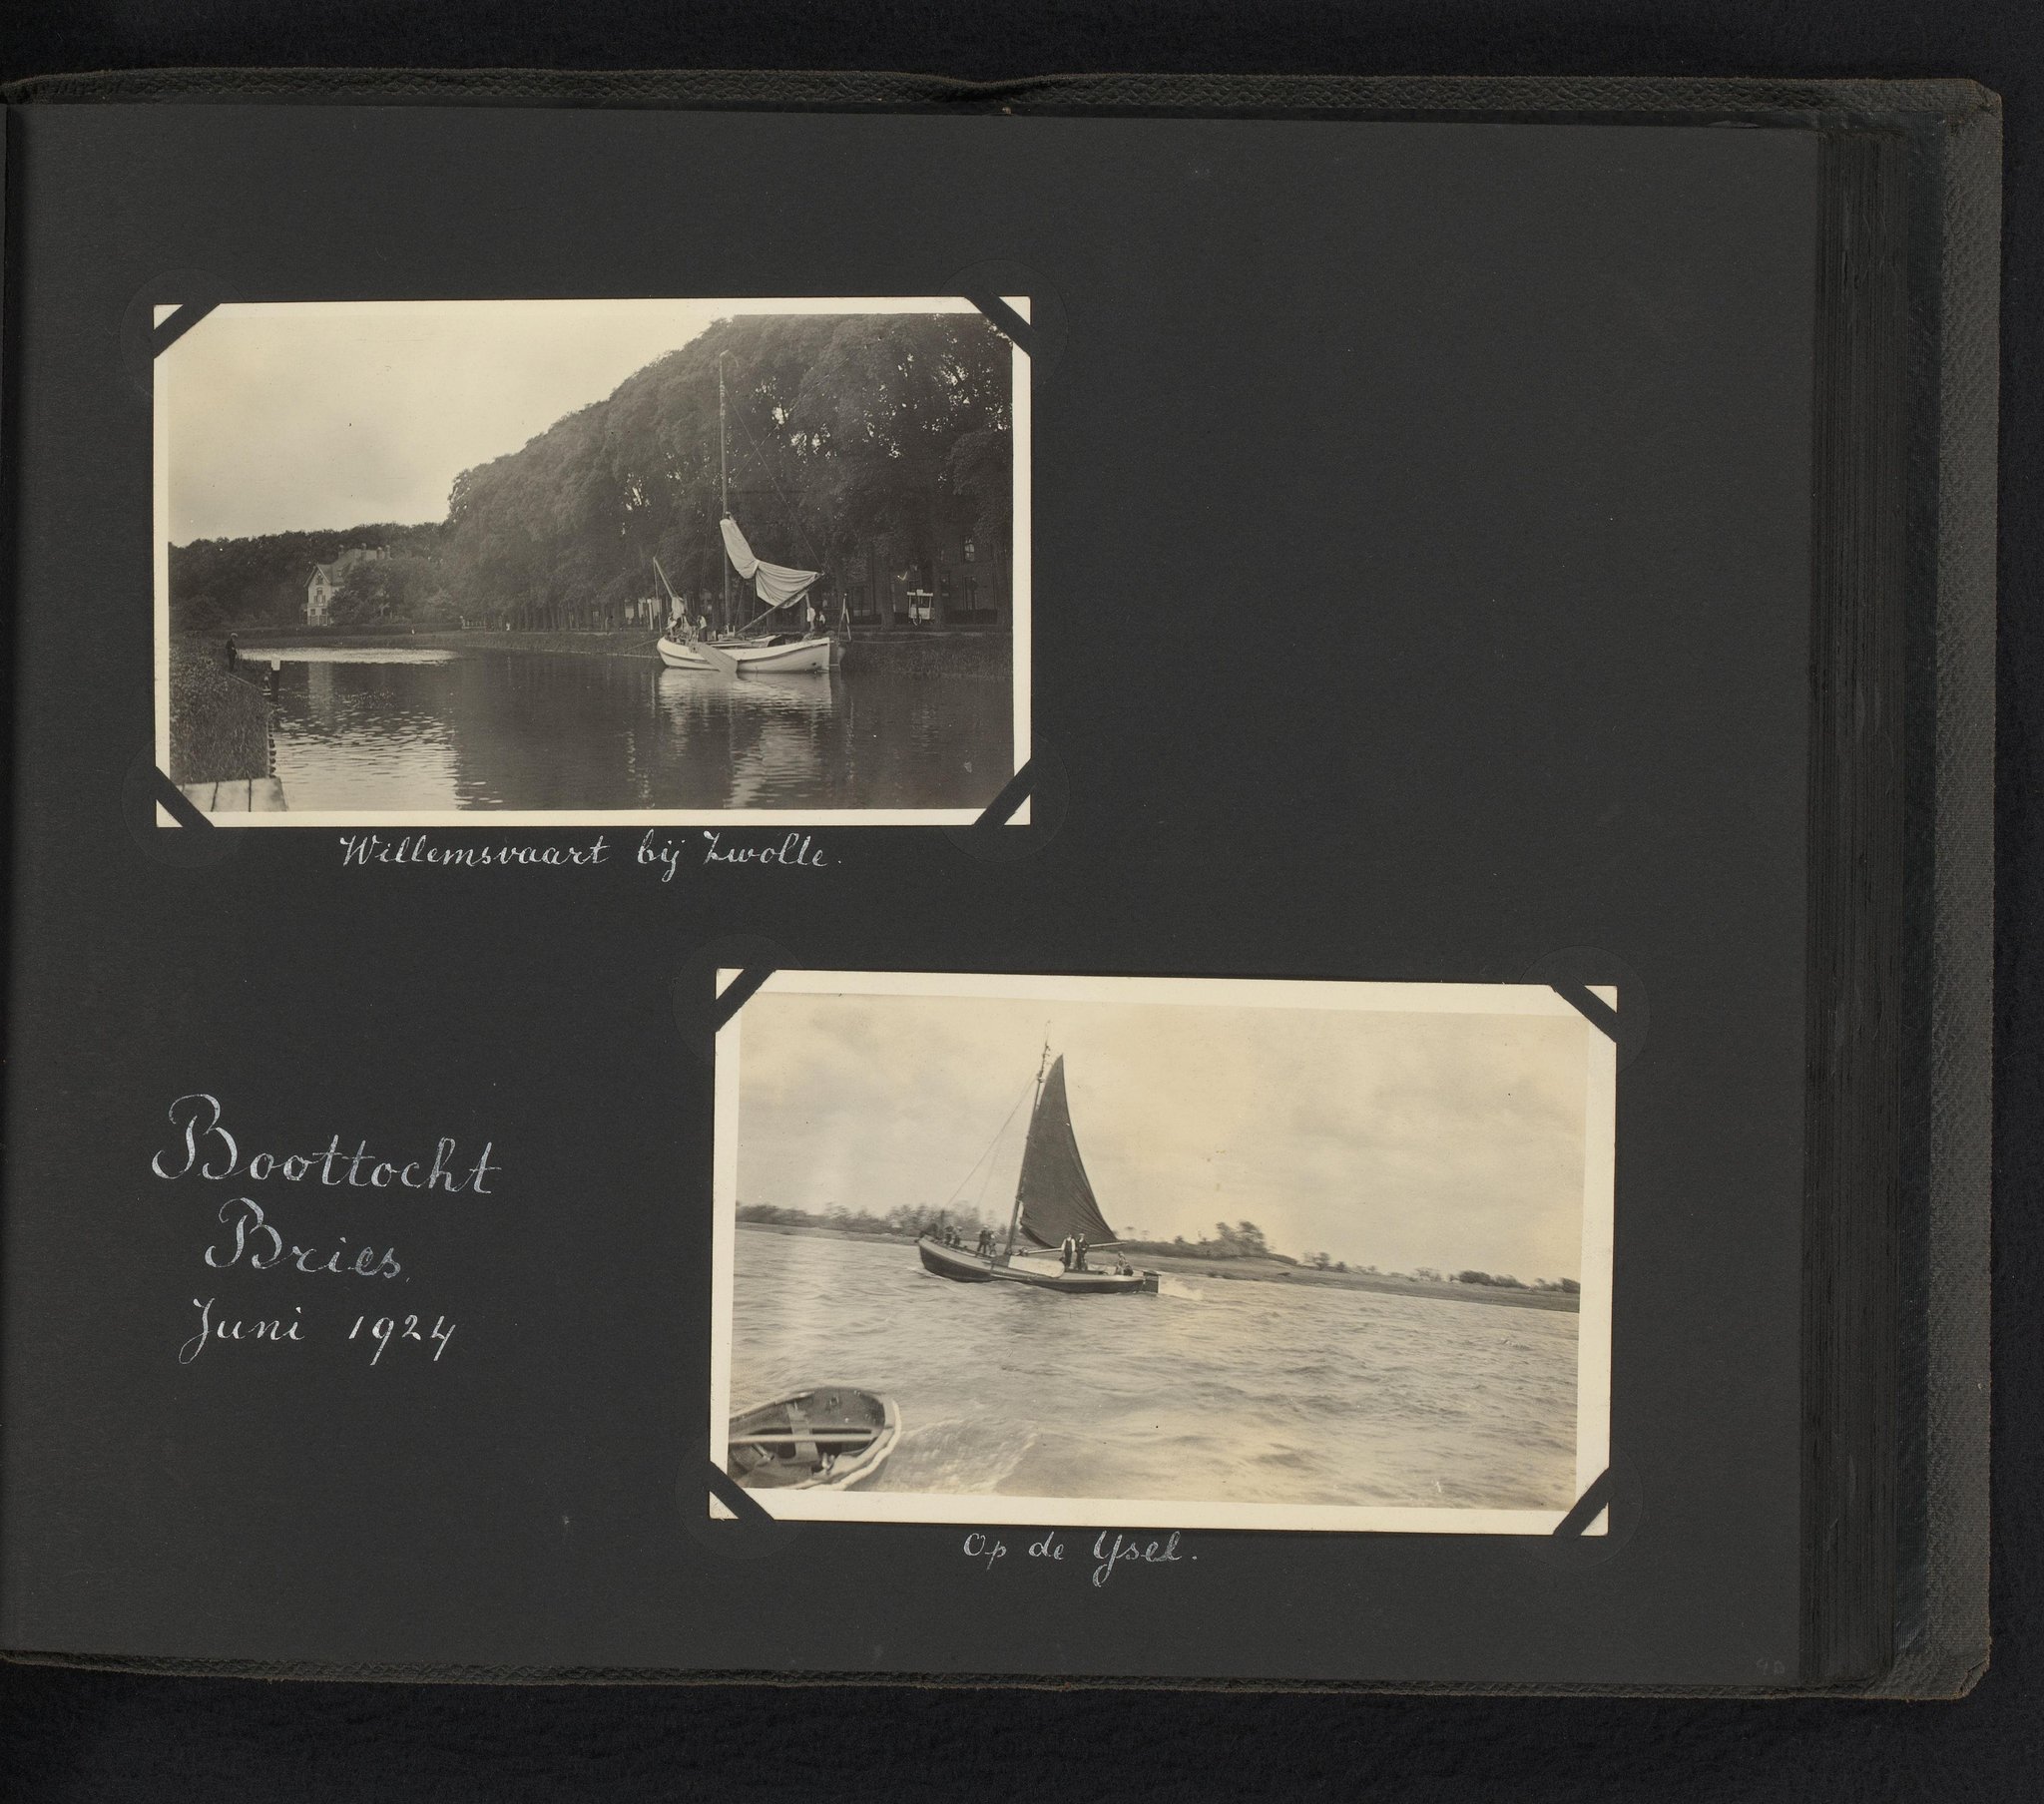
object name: photograph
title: Boottocht Bries Juni 1924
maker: hendrik herman van den berg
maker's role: amateurfotograaf, jurist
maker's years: 1875-1944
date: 1906-1924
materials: paper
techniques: gelatin silver print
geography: overijssel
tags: sailing-ship, sailing-boat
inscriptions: inscription: ‘Willemsvaart bij Zwolle’, inscription: ‘Op de IJsel’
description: Deze foto's maken deel uit van een album.